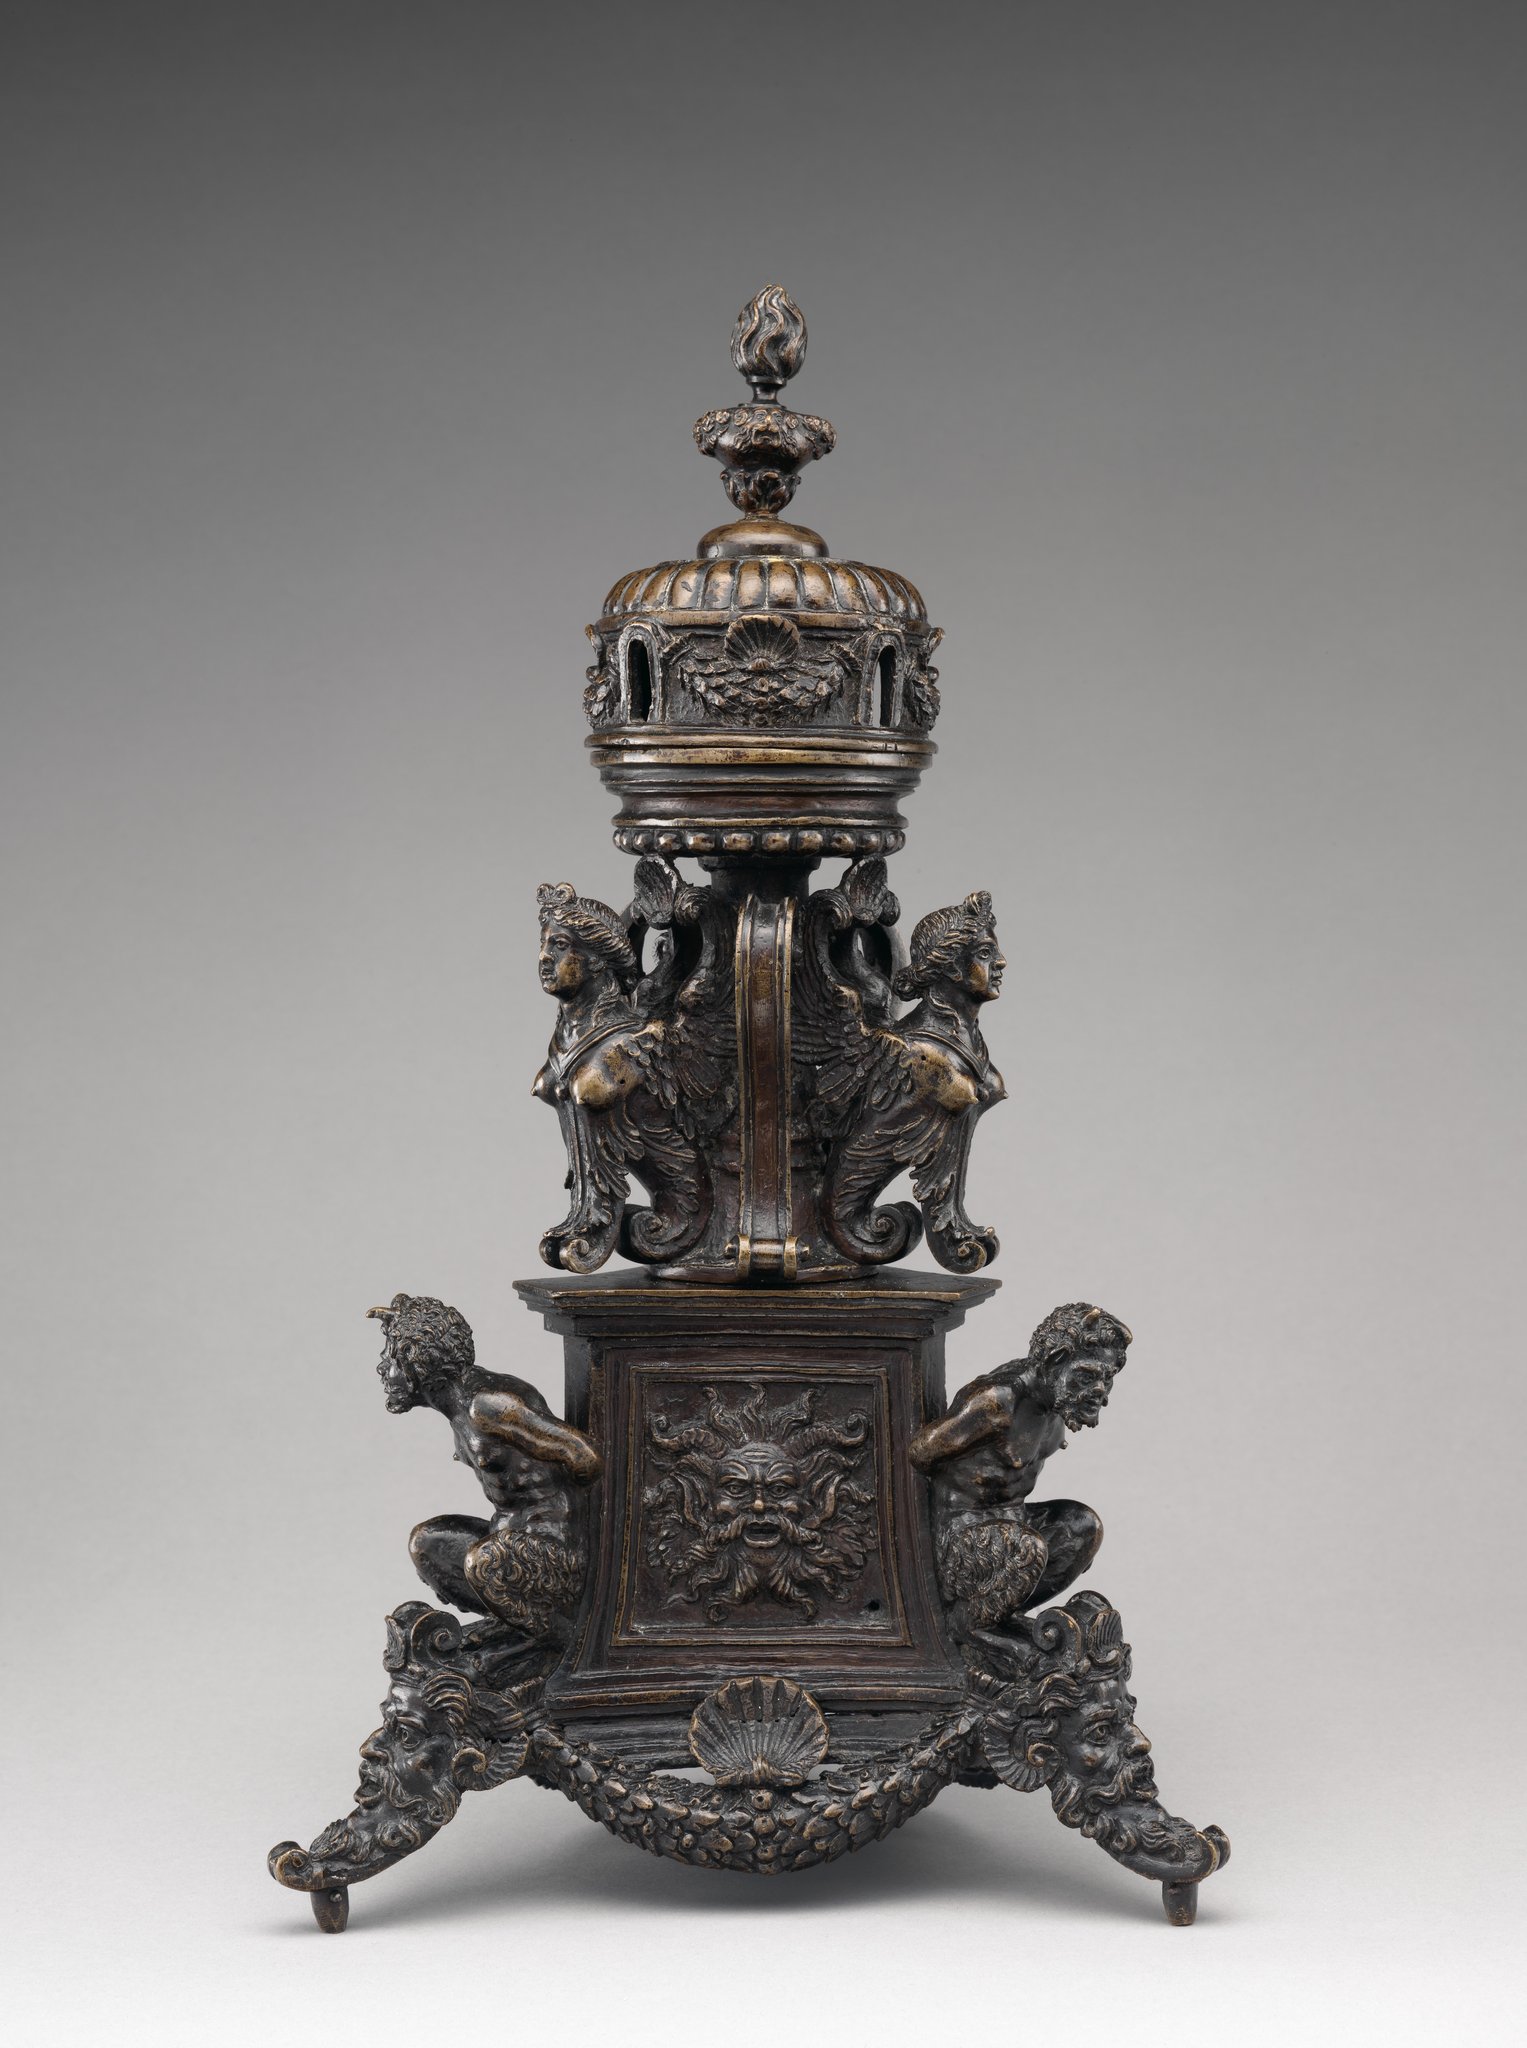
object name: incense burner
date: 1530-1540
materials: bronze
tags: sphinx,satyrs